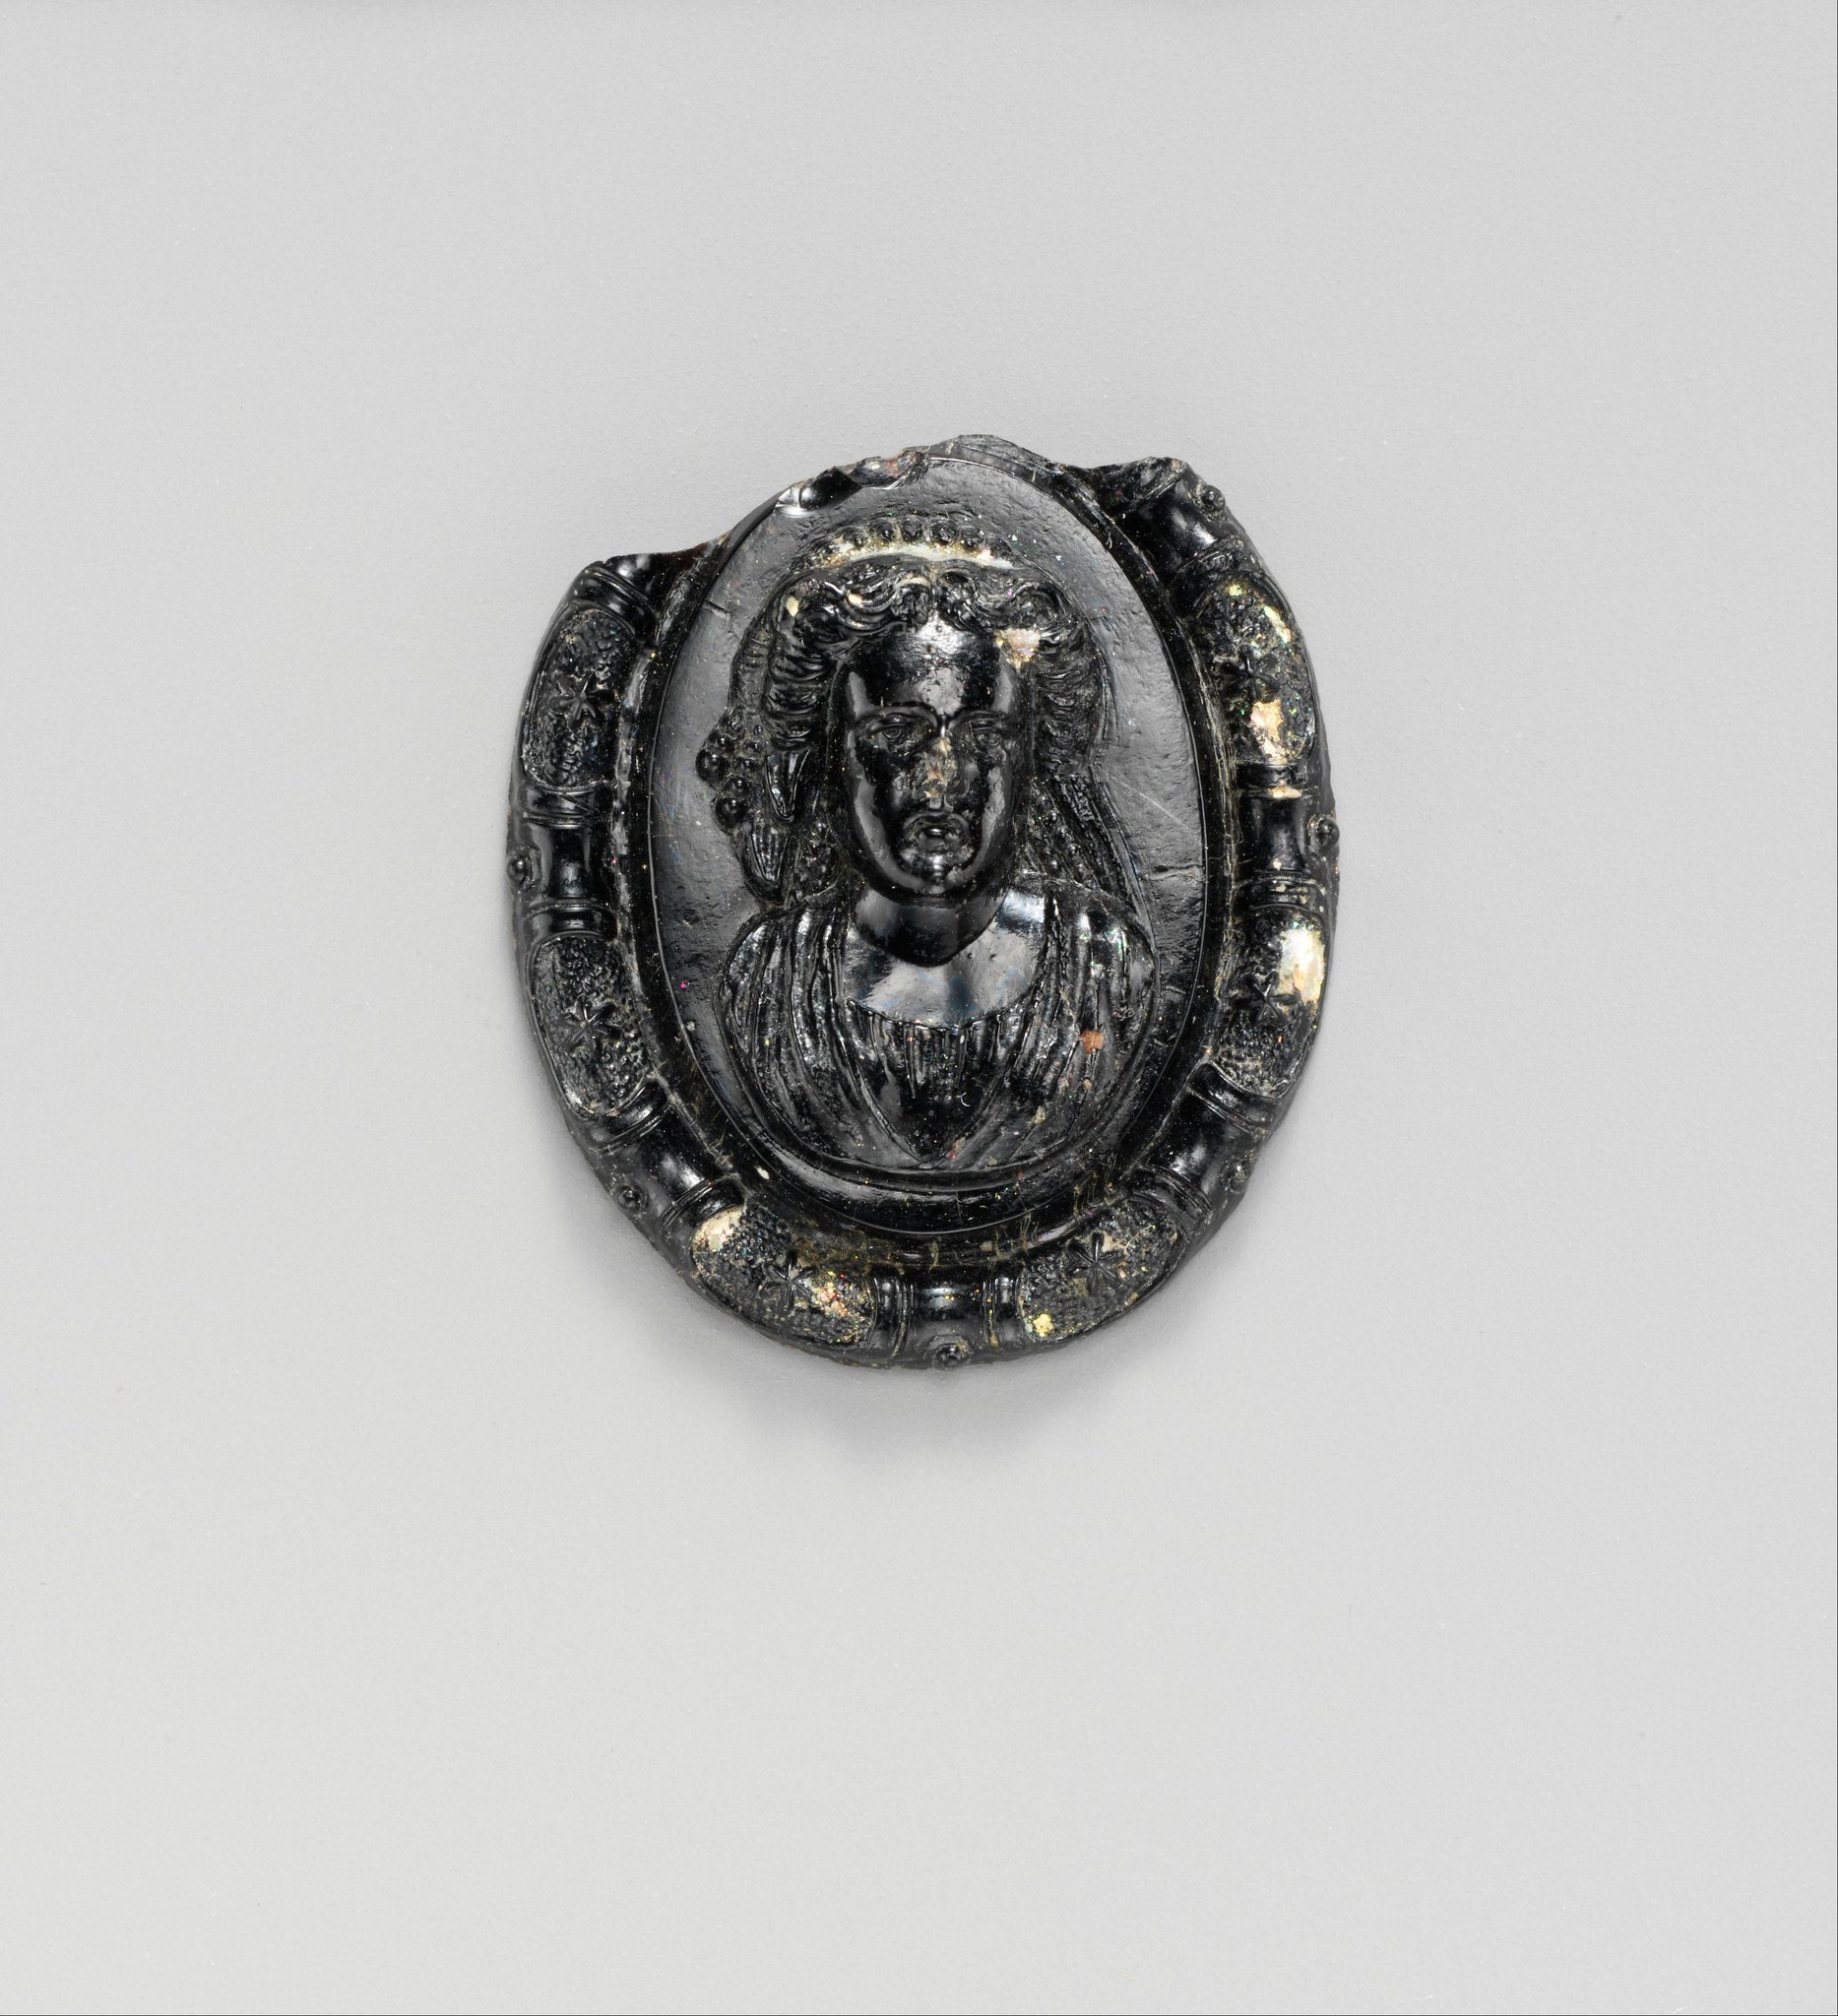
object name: roundel, medallion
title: Glass medallion with the bust of a woman or goddess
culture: roman, cypriot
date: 1-100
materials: glass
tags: women,goddess